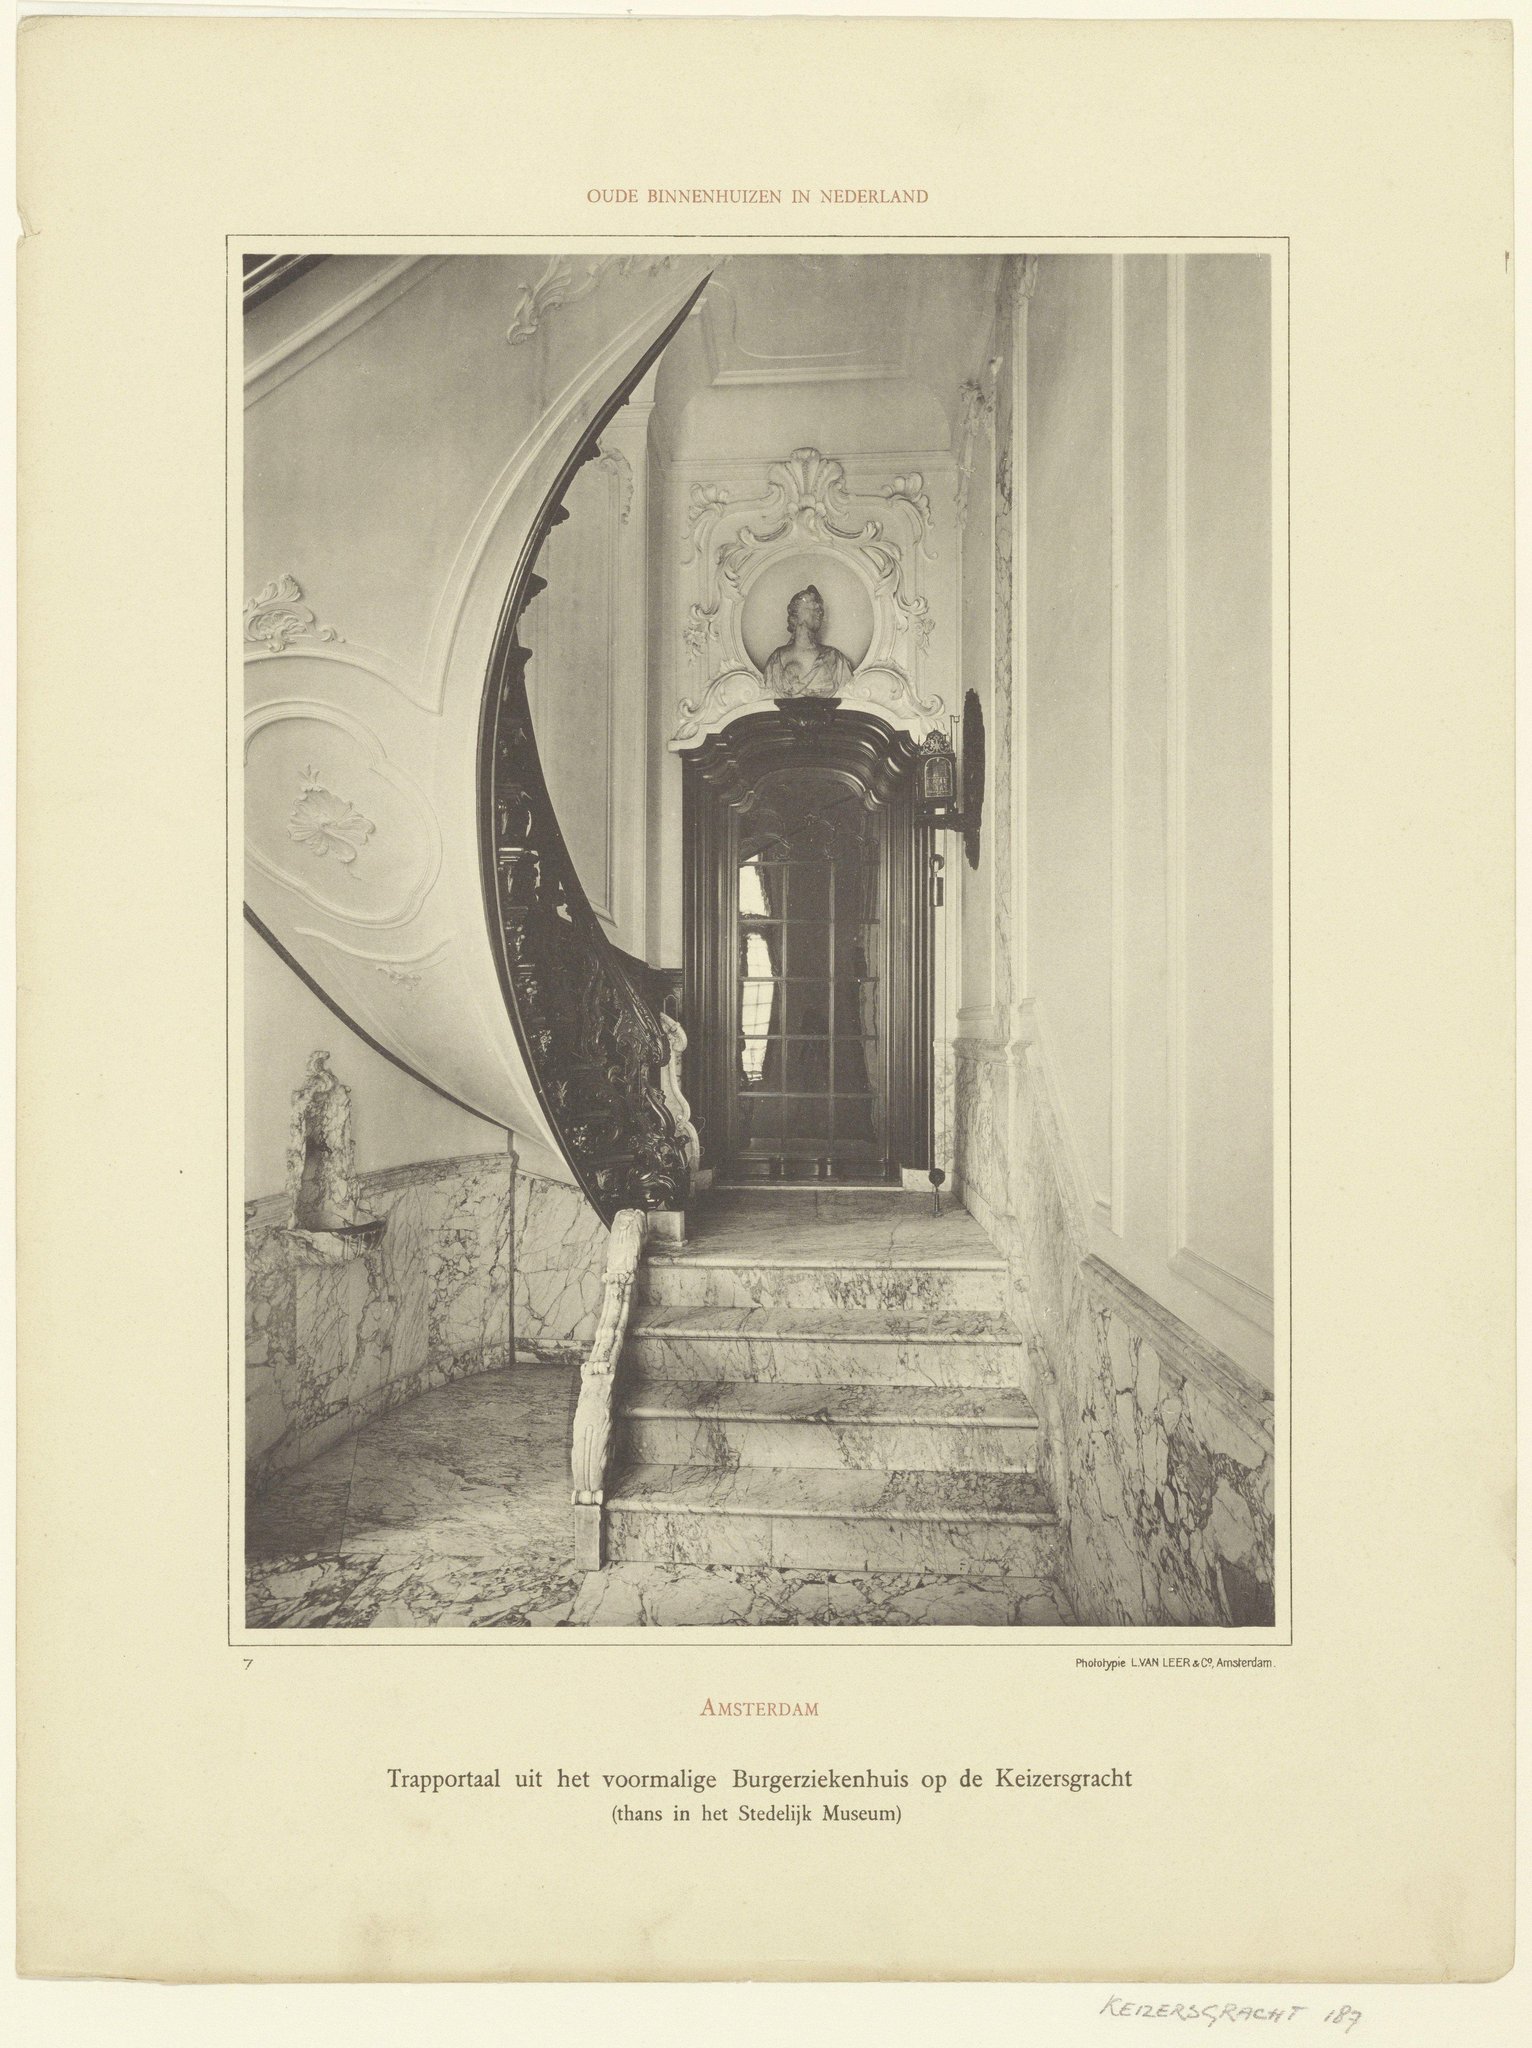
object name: architectural element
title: Onderdelen van het trapportaal uit het pand aan de Keizersgracht 187 te Amsterdam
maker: Anonymous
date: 1740-1760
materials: wood, marble